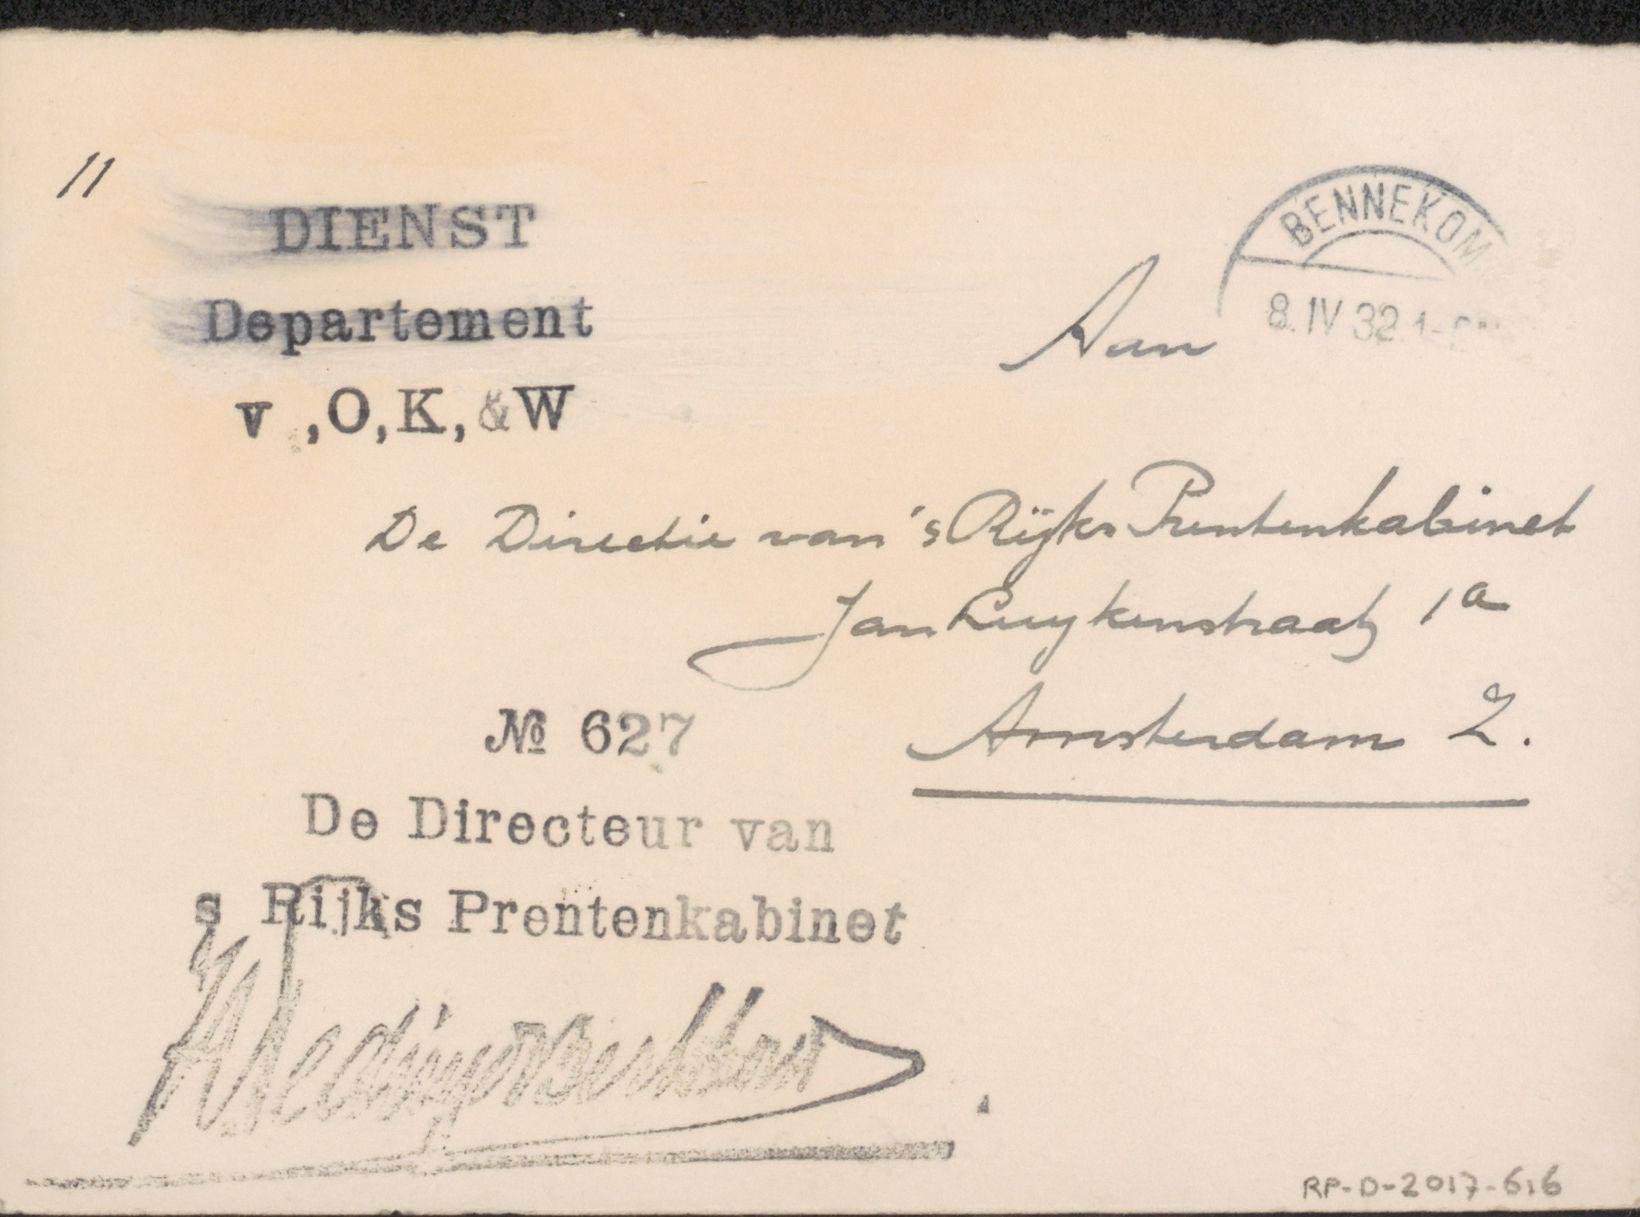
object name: postcard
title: Briefkaart aan jonkheer Hendrik Teding van Berkhout (1879-1969)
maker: dick ket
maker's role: draughtsman, print maker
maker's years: 1902-1940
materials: cardboard, ink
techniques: pen, writing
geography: bennekom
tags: print room, haarlem, amsterdam, jonkheer hendrik teding van berkhout (1879-1969)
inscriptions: name: ‘DIENST/ Departement/ V,O,K,W,/ No 627/ De Directeur van/ s Rijks Prentenkabinet/ HTedingvBerkhout’